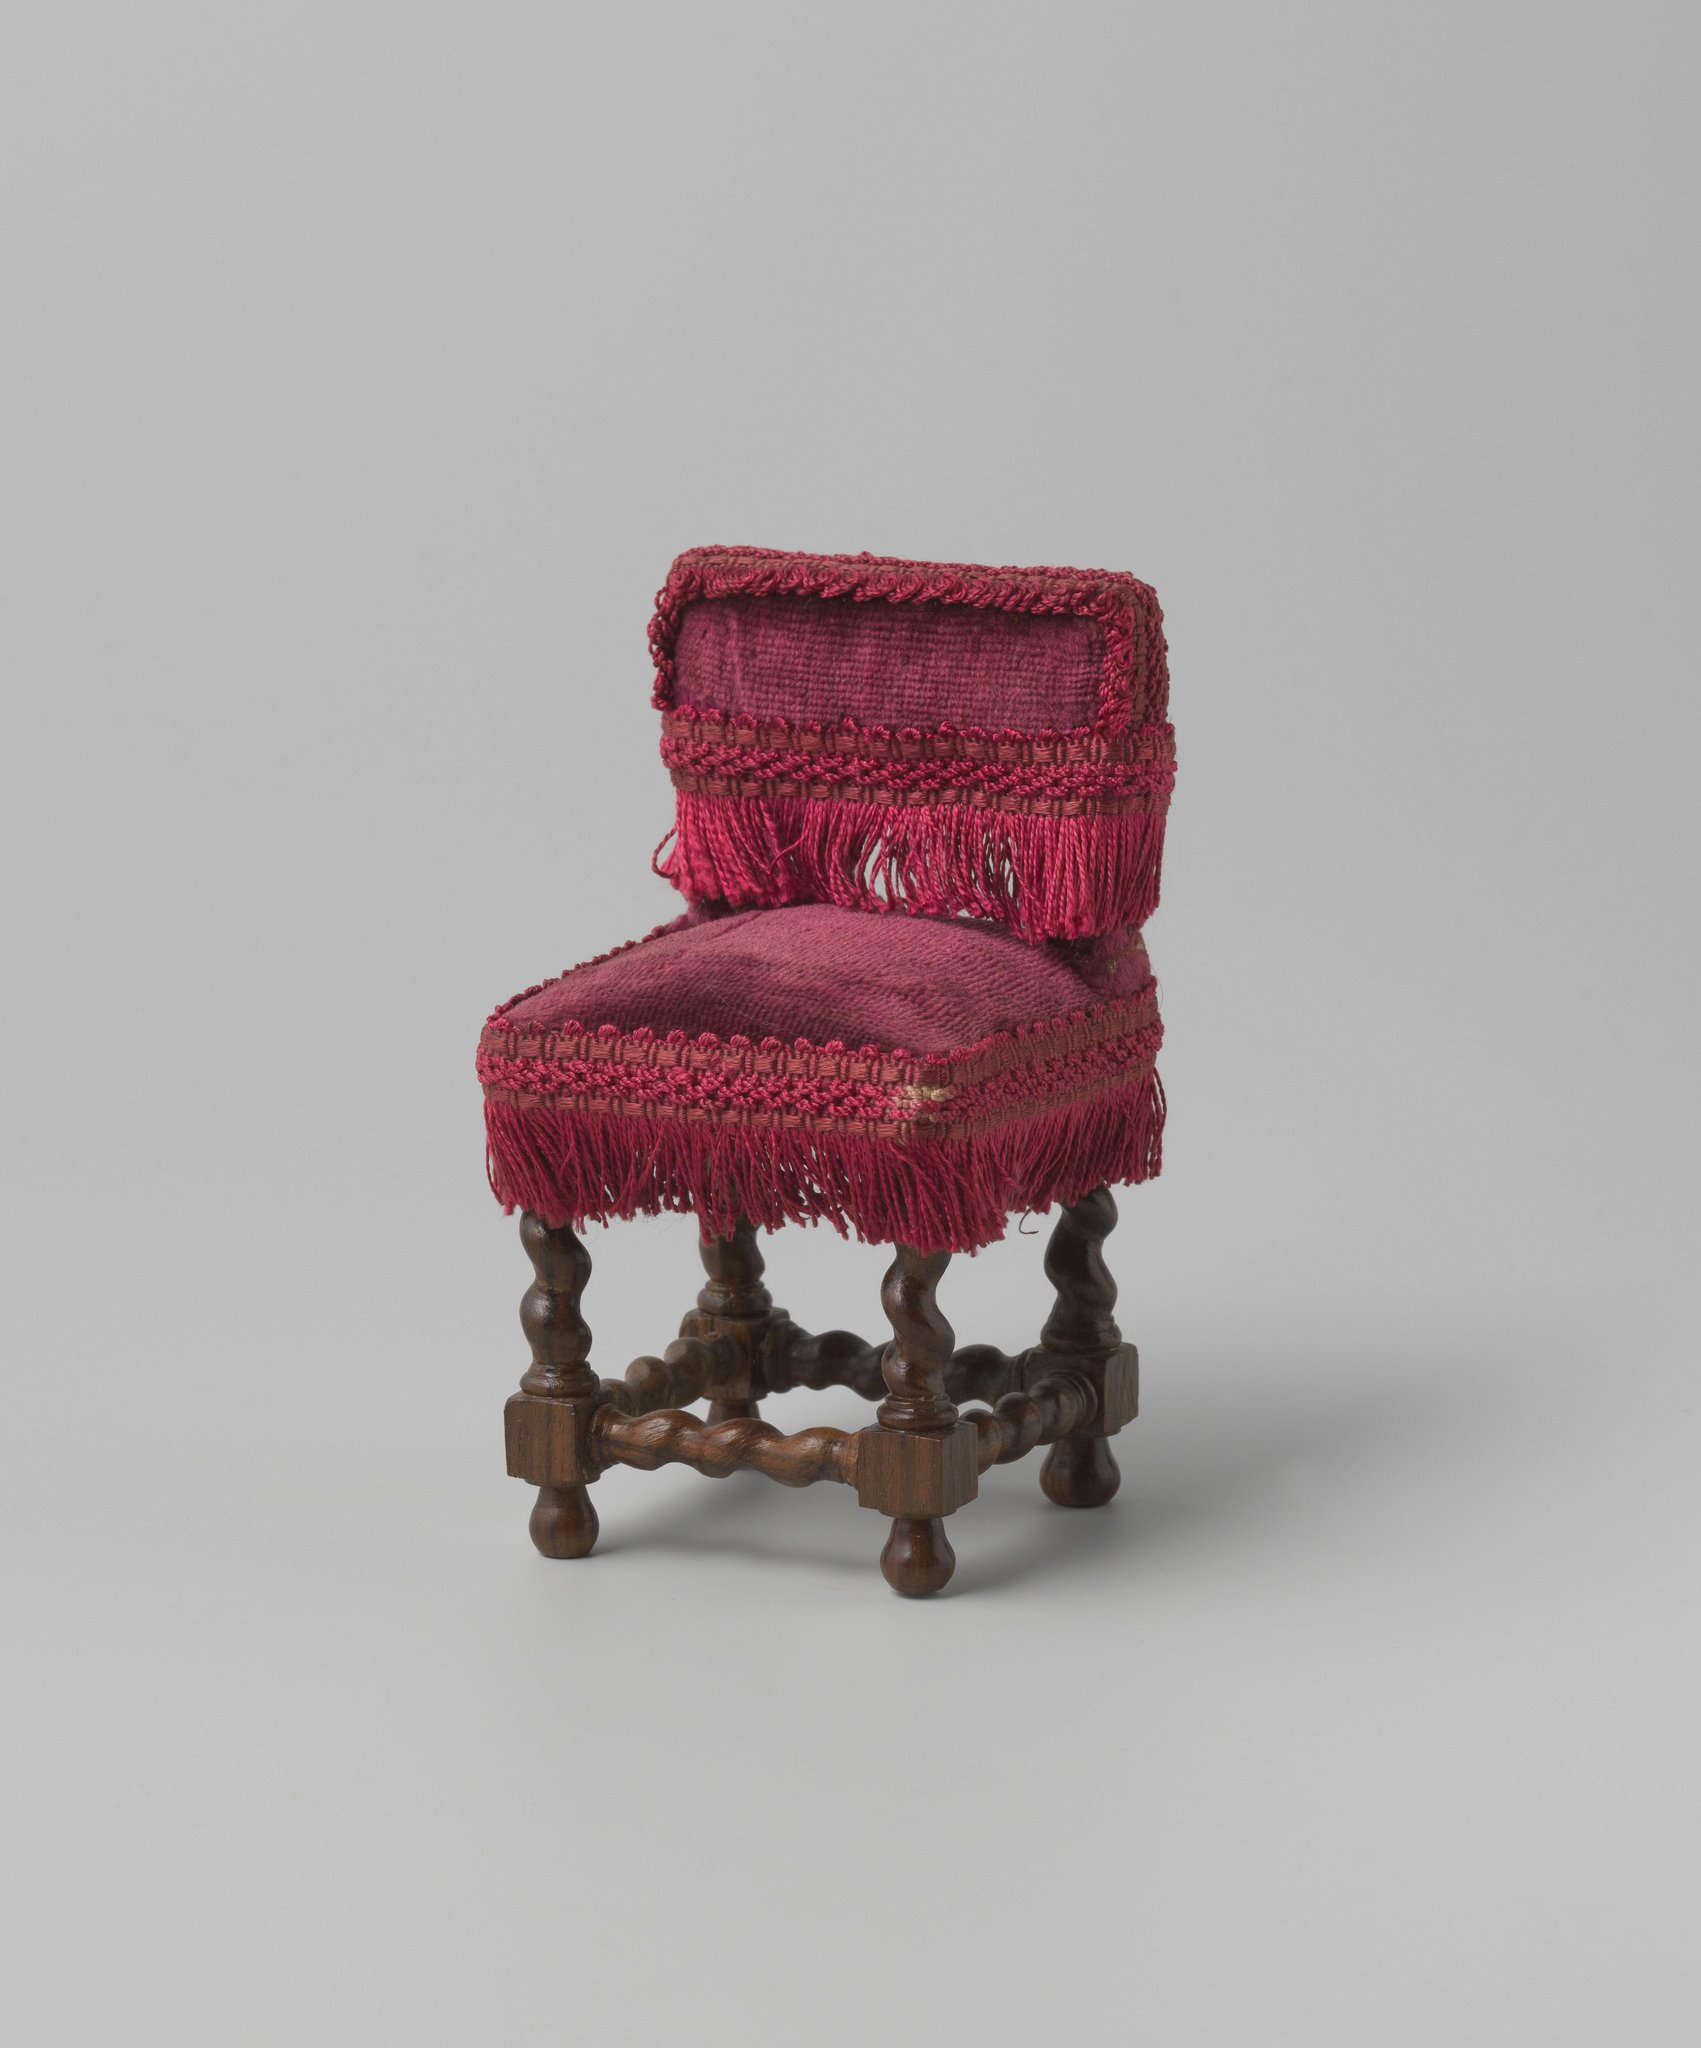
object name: miniature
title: Stoel van notenhout, bekleed met rood fluweel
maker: Anonymous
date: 1676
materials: linen, silk, wood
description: Stoel van notenhout met getorste poten en dwarssporten, met elkaar verbonden in huizen, lage rugleuning, vervaardigd uit een stuk notenhout. De zitting en rug bekleed met bordeaurode zijdefluweel, afgezet met smal, zijden passement met lussen en breder passement met losse franje. Zitting gevuld op linnen onderlaag. Achterstijl tussen zitting en rug eveneens bekleed met fluweel.